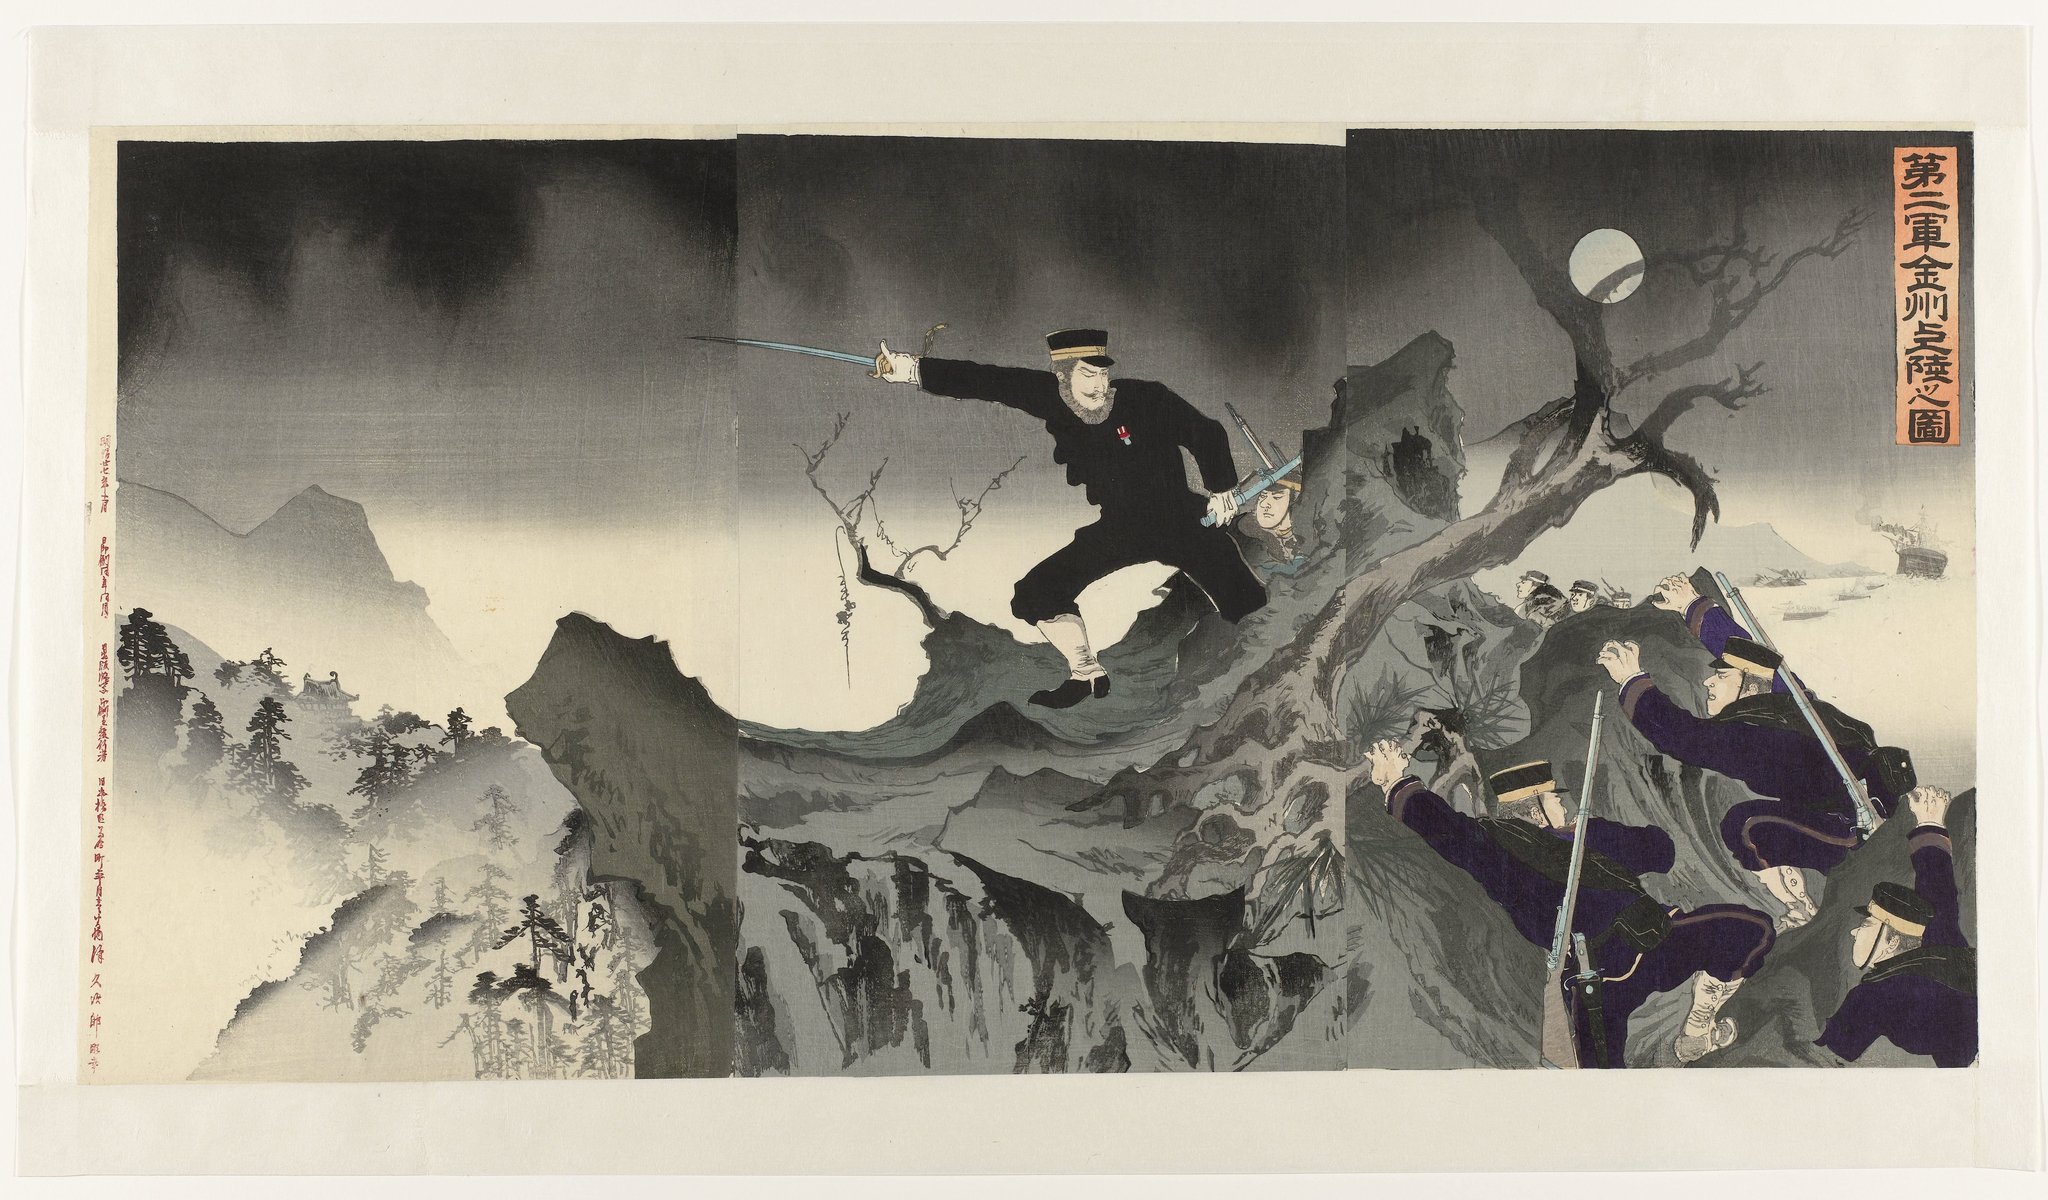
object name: triptych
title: De tweede divisie komt aan land bij Liaodong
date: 1894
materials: paper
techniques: woodcut, polish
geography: japan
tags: commander-in-chief, general, marshal, hacking and thrusting weapons: sword, rock-formations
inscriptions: collector's mark: Lugt 2228, label:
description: Generaal Yamaji Motoharu met getrokken zwaard op een rots, achter hem volgen meerdere Japanse soldaten.Terwijl de eerste divisie van het Japanse leger via Korea Mantsjoerije binnen viel, ging de tweede divisie onder leiding van generaal Yamaji aan land via het Liaodong schiereiland. Dit gebeurde op 24 oktober 1894, tijdens de Eerste Chinees-Japanse Oorlog (1894-1895).